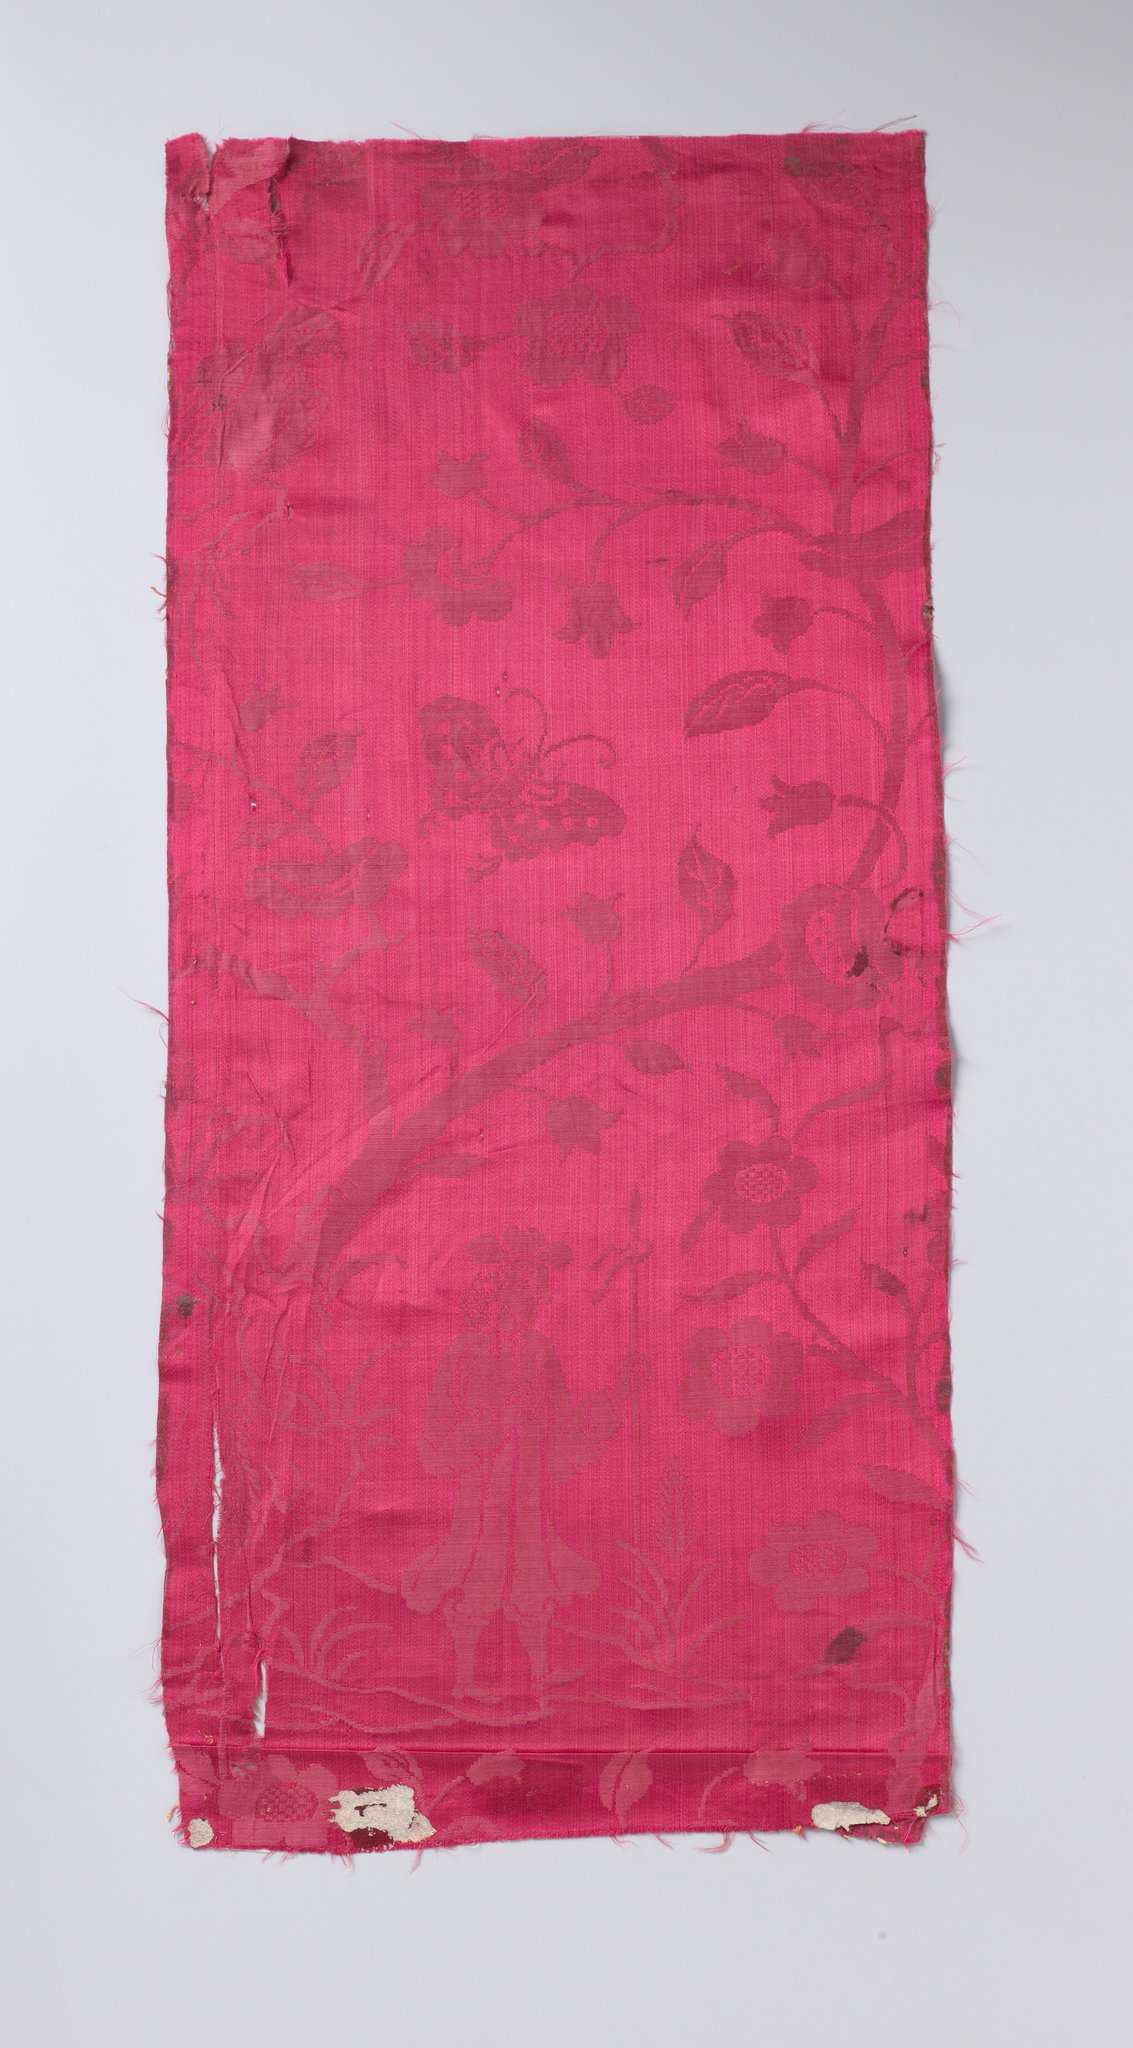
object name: zijdesatijn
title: Fragment fuchsia roze zijdesatijn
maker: Anonymous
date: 1700-1750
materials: silk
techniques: damask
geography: france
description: Fragment fuchsia rozezijdeweefsel. Patroon: Aan de onderzijde staat een man in een lange jas met in zijn linkerhand een stok. Links van de man begint een zich naar boven slingerende boom met bladeren en bloemen. Tussen de slingerende boomtakken is een vlinder en een vogel afgebeeld. Langs de randen enkele scheuren.